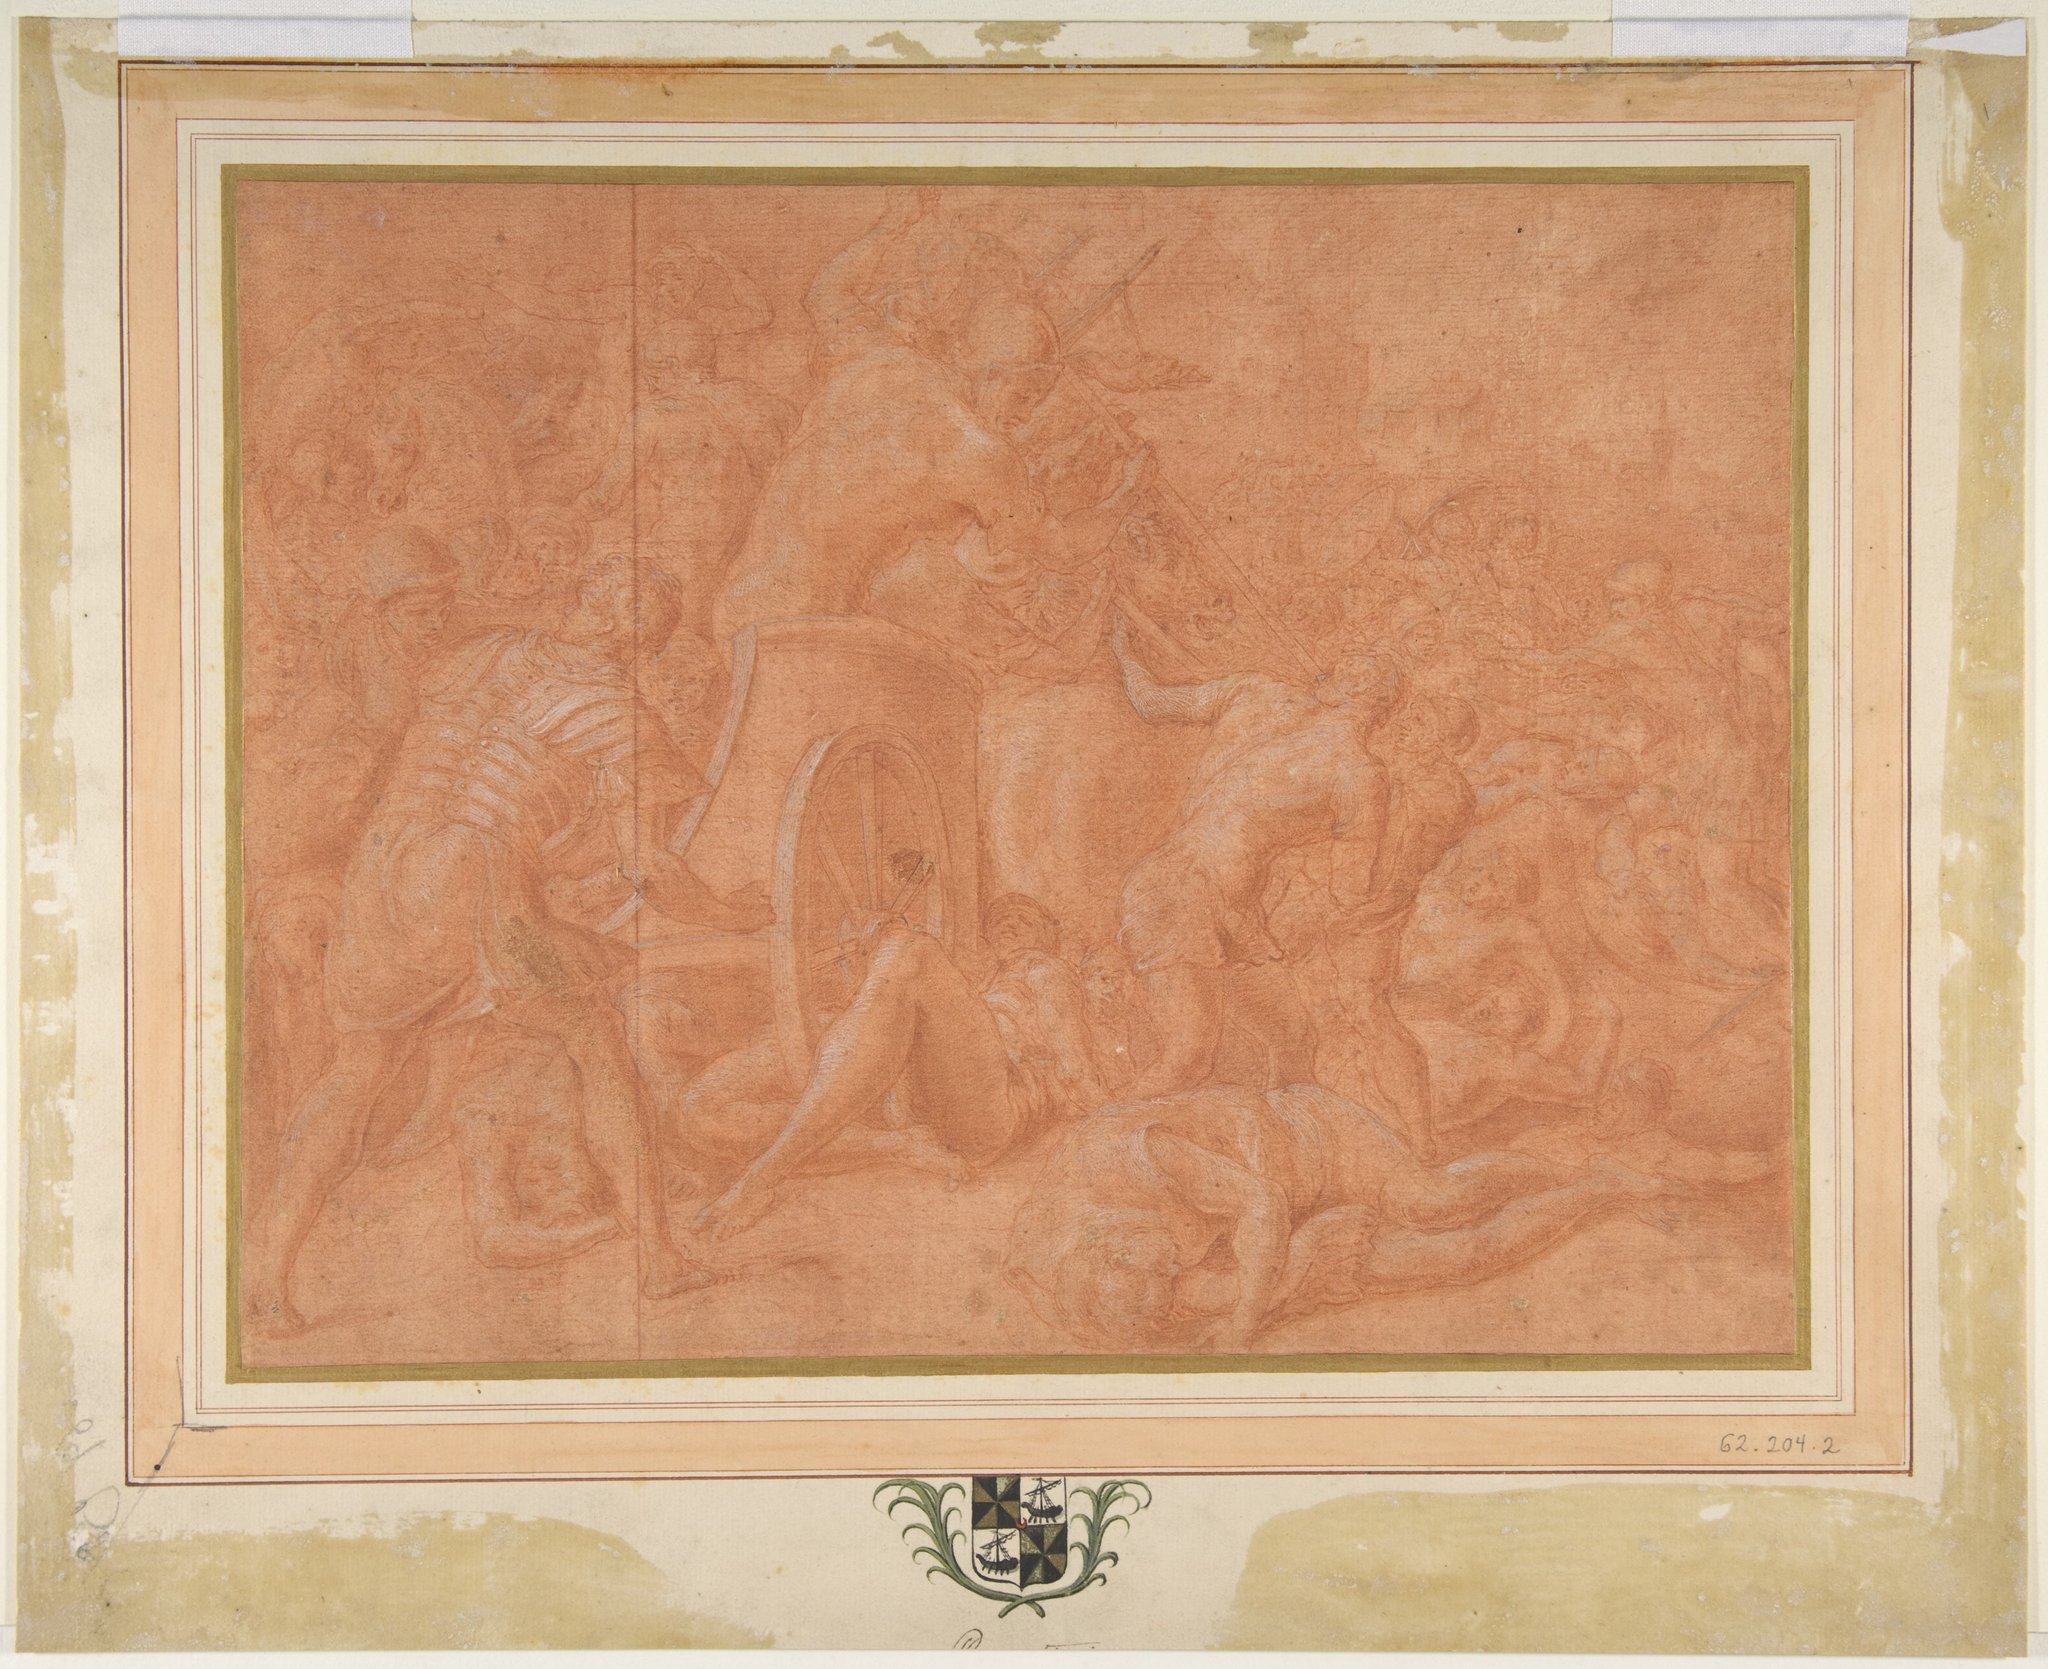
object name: drawing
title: Ulysses and His Companions Fighting the Cicones Before the City of Ismaros, Study for a Destroyed Fresco in the Galerie d'Ulysee, Chateau de Fontainebleau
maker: francesco primaticcio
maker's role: artist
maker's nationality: italian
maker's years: 1504-1570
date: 1555-1560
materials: chalk, gouache, paper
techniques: highlighting, wash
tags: battles,soldiers,men,death